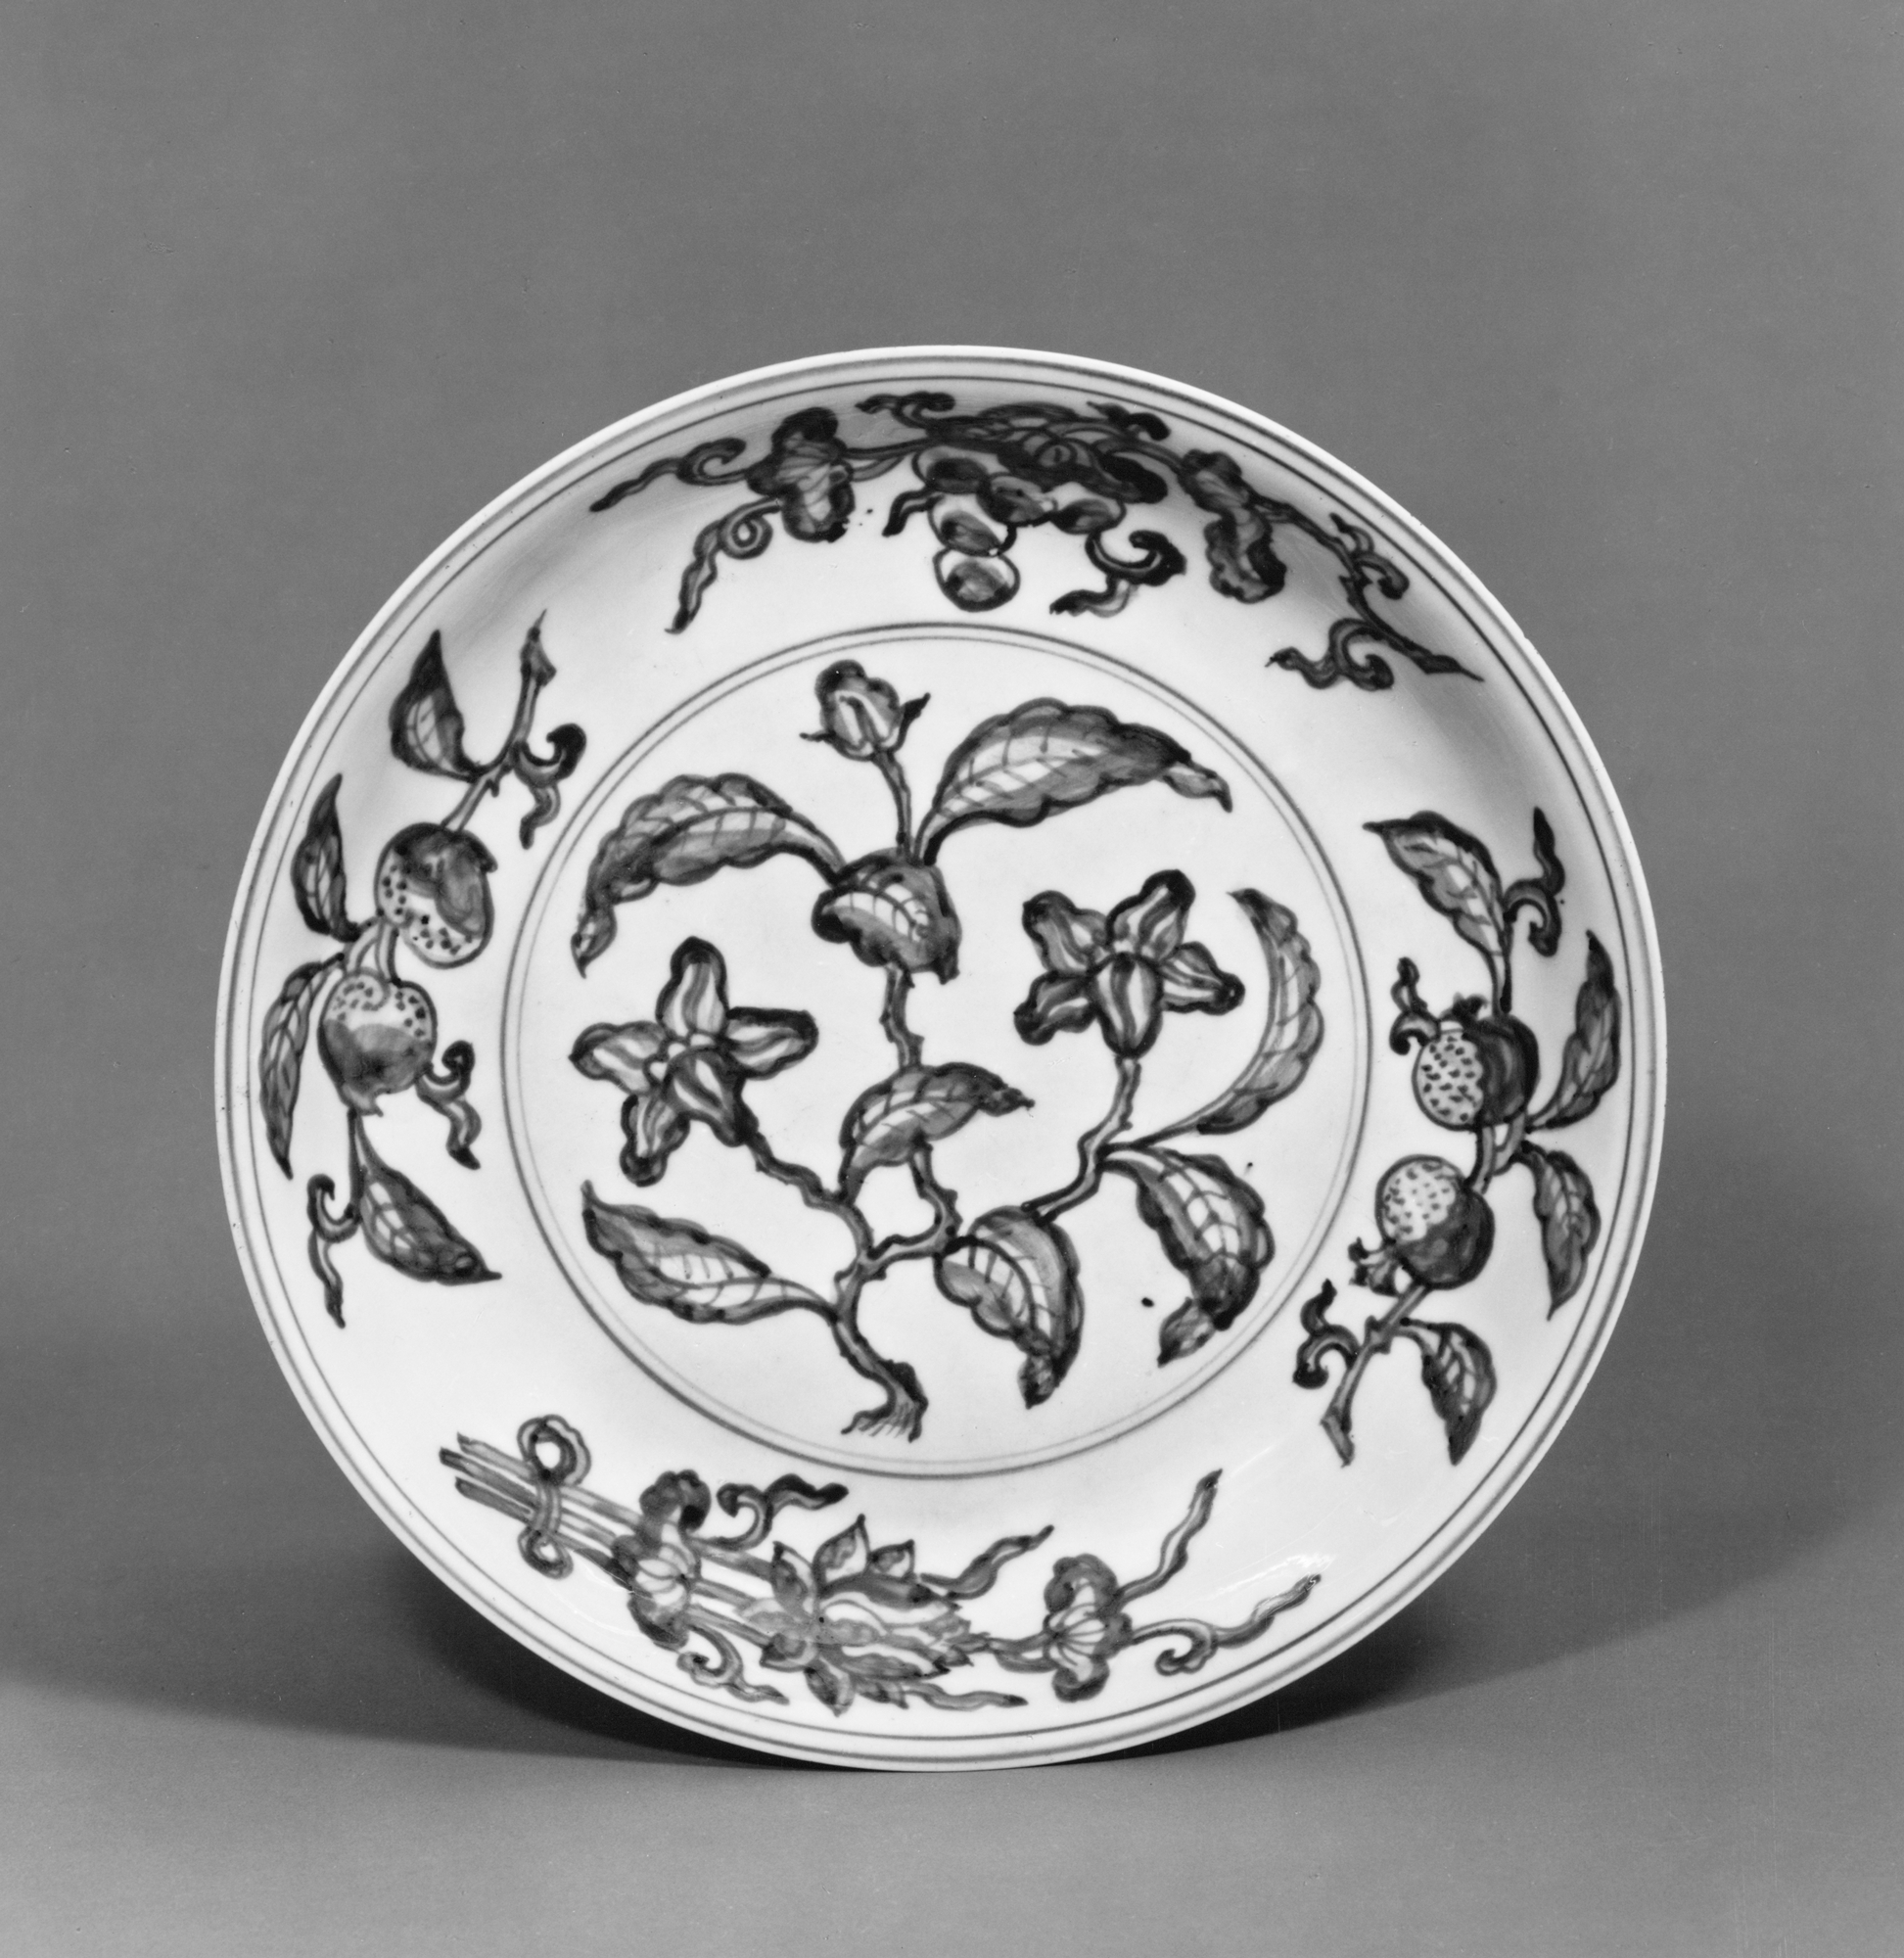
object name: dish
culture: chinese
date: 1506-1521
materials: enamel, porcelain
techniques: overglaze, painting, underglaze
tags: fruit,flowers,leaves